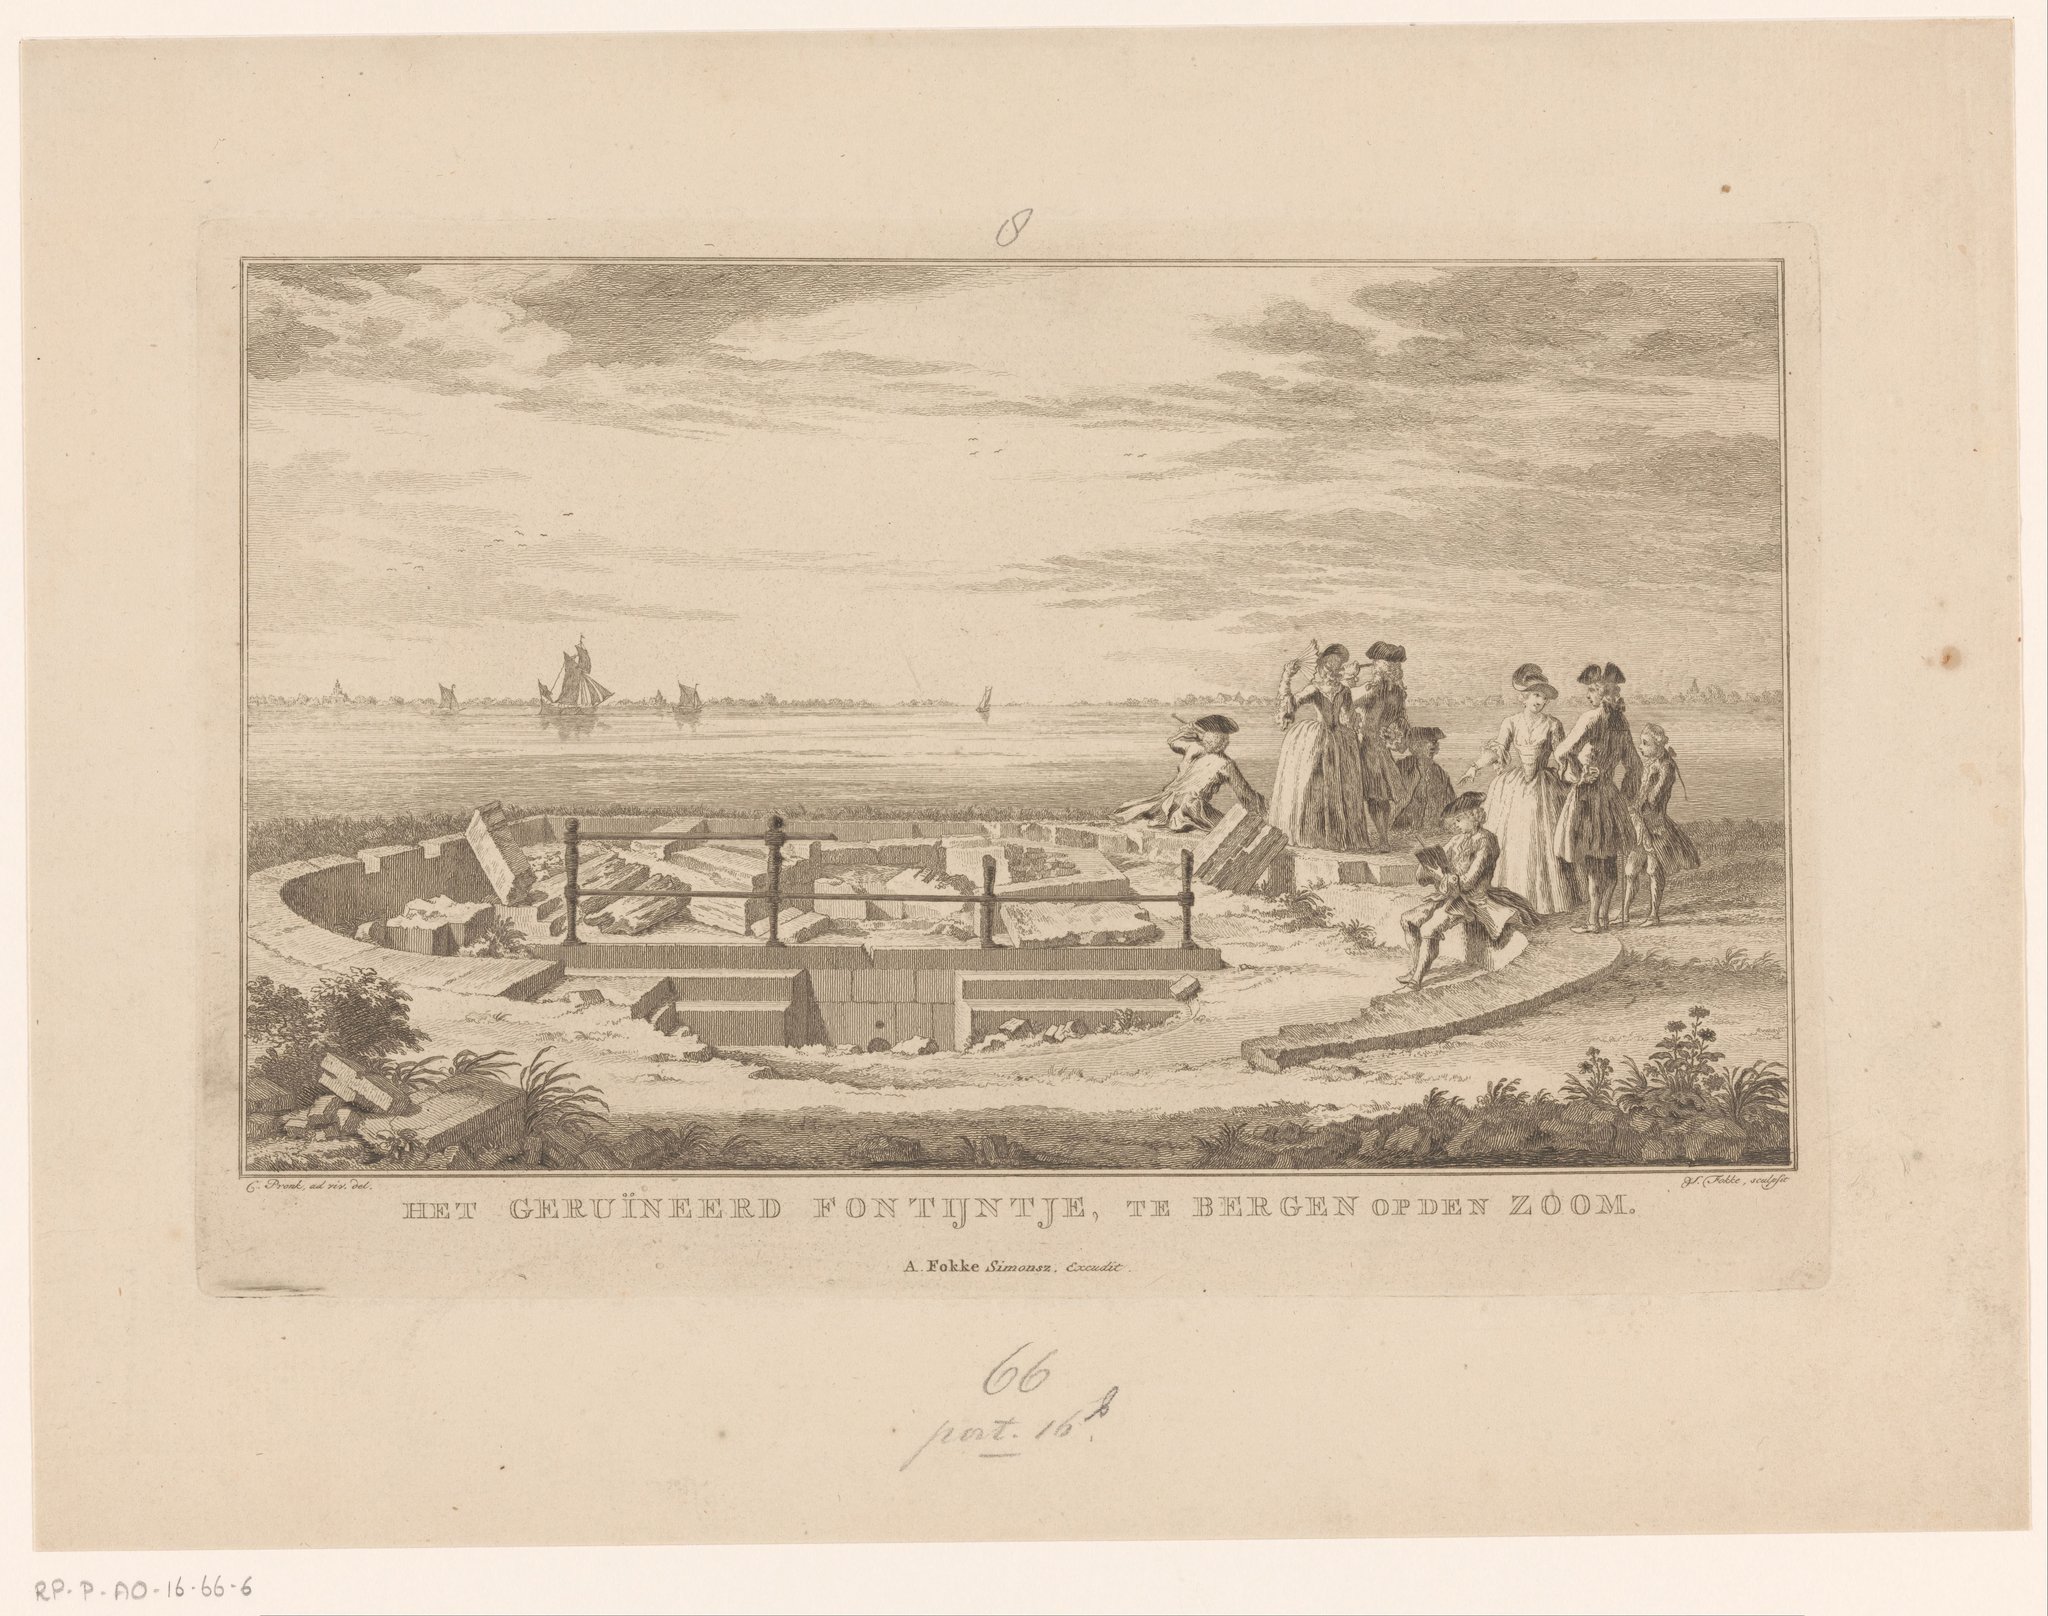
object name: print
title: Tien gezichten van de ruïnes na het beleg en de verwoesting van Bergen op Zoom in 1747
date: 1772-1780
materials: paper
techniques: etching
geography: amsterdam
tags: landscape with ruins, ornamental fountain (in village), bergen op zoom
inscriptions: collector's mark: Lugt 2228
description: Prent ook gebruikt in: Beschryving der stad Bergen op den Zoom (…). 1e druk. Amsterdam: Arend Fokke Simonsz., 1780. Muller geeft aan dat de prenten door Simon Fokke in 1772 naar de tekeningen van Pronk uit 1748 zijn vervaardigd. In de Collecties Thuis in Brabant (collecties in Brabantse musea en archieven) is een ontwerptekening (met inv.nr.: BC-Tha oai:tha.uvt.nl:709121) voor deze prent in de serie bewaard met de annotatie: Hoogstraat. na t Leven geschest (sic) door C.Pronk 1748. opgetekent door S. Fokke 1772.